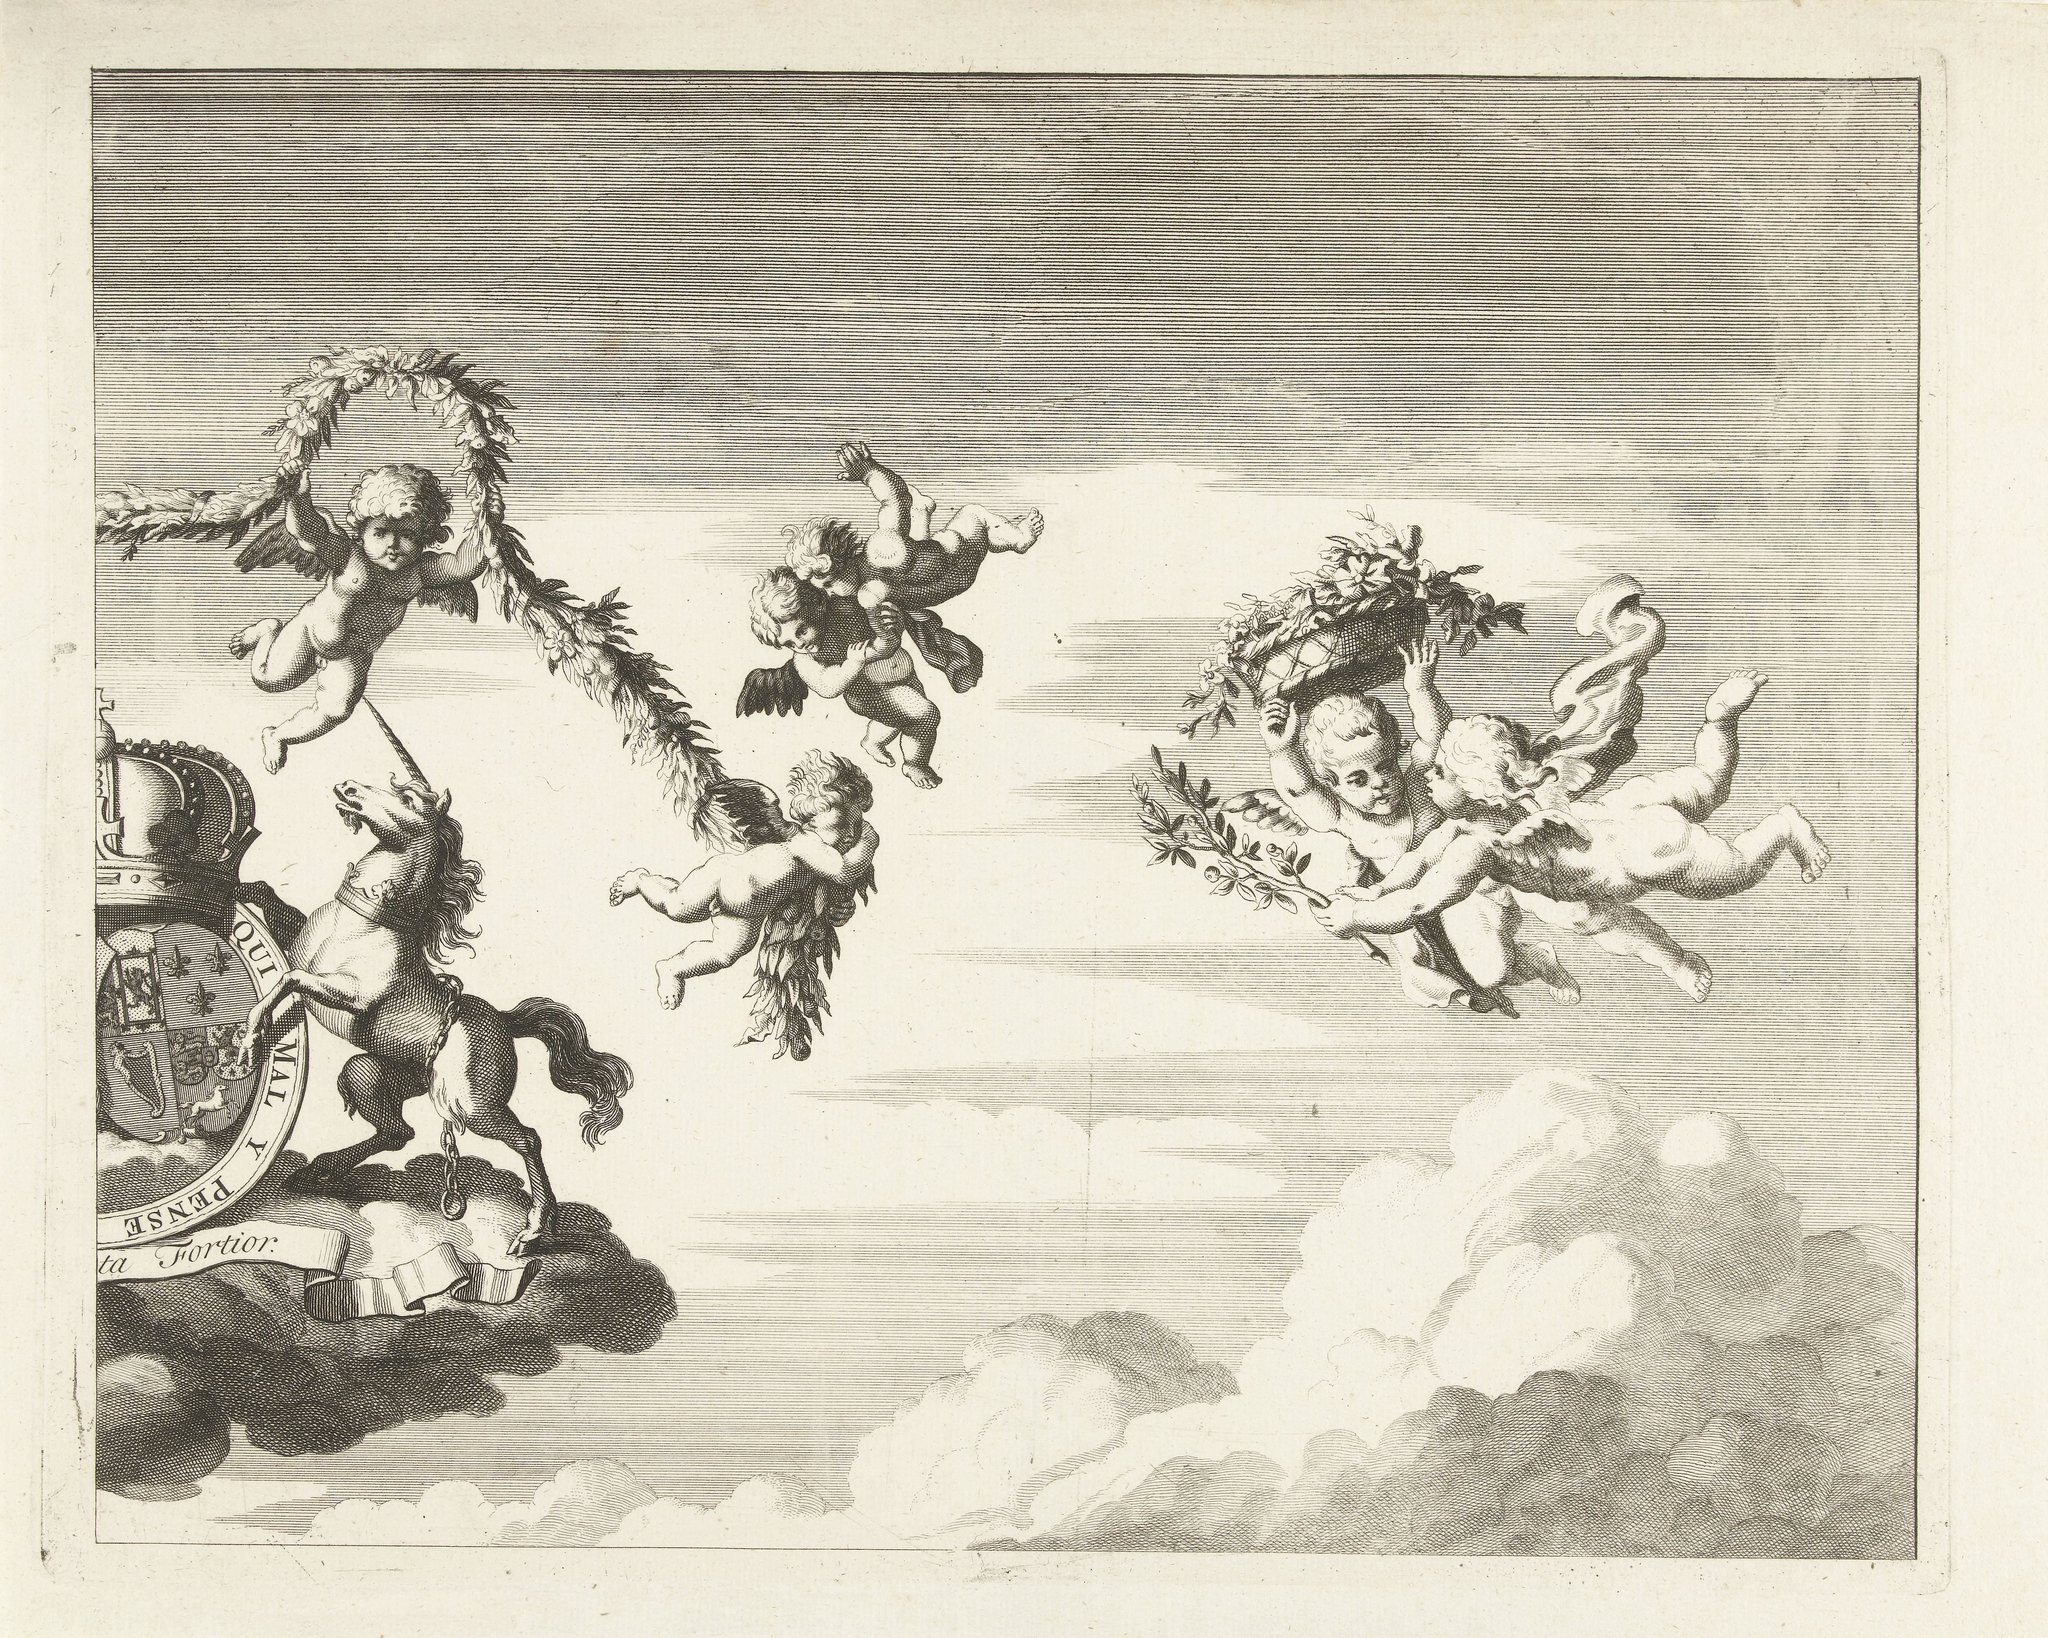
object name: print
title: Wapens van prins Willem IV en Anna van Engeland, 1734 (rechterhelft)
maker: Anonymous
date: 1734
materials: paper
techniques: engraving, etching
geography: northern netherlands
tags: the hague, willem iv (prins van oranje-nassau), anna van hannover, armorial bearing, heraldry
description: De wapens van prins Willem IV en prinses Anna van Engeland, gehuwd op 25 maart 1734, in de wolken met engeltjes met een festoen, aan de rechterzijde van het wapen de Britse eenhoorn als wapendrager. Ongemonteerd geheel bestaande uit twee delen waarvan dit de rechterhelft is.